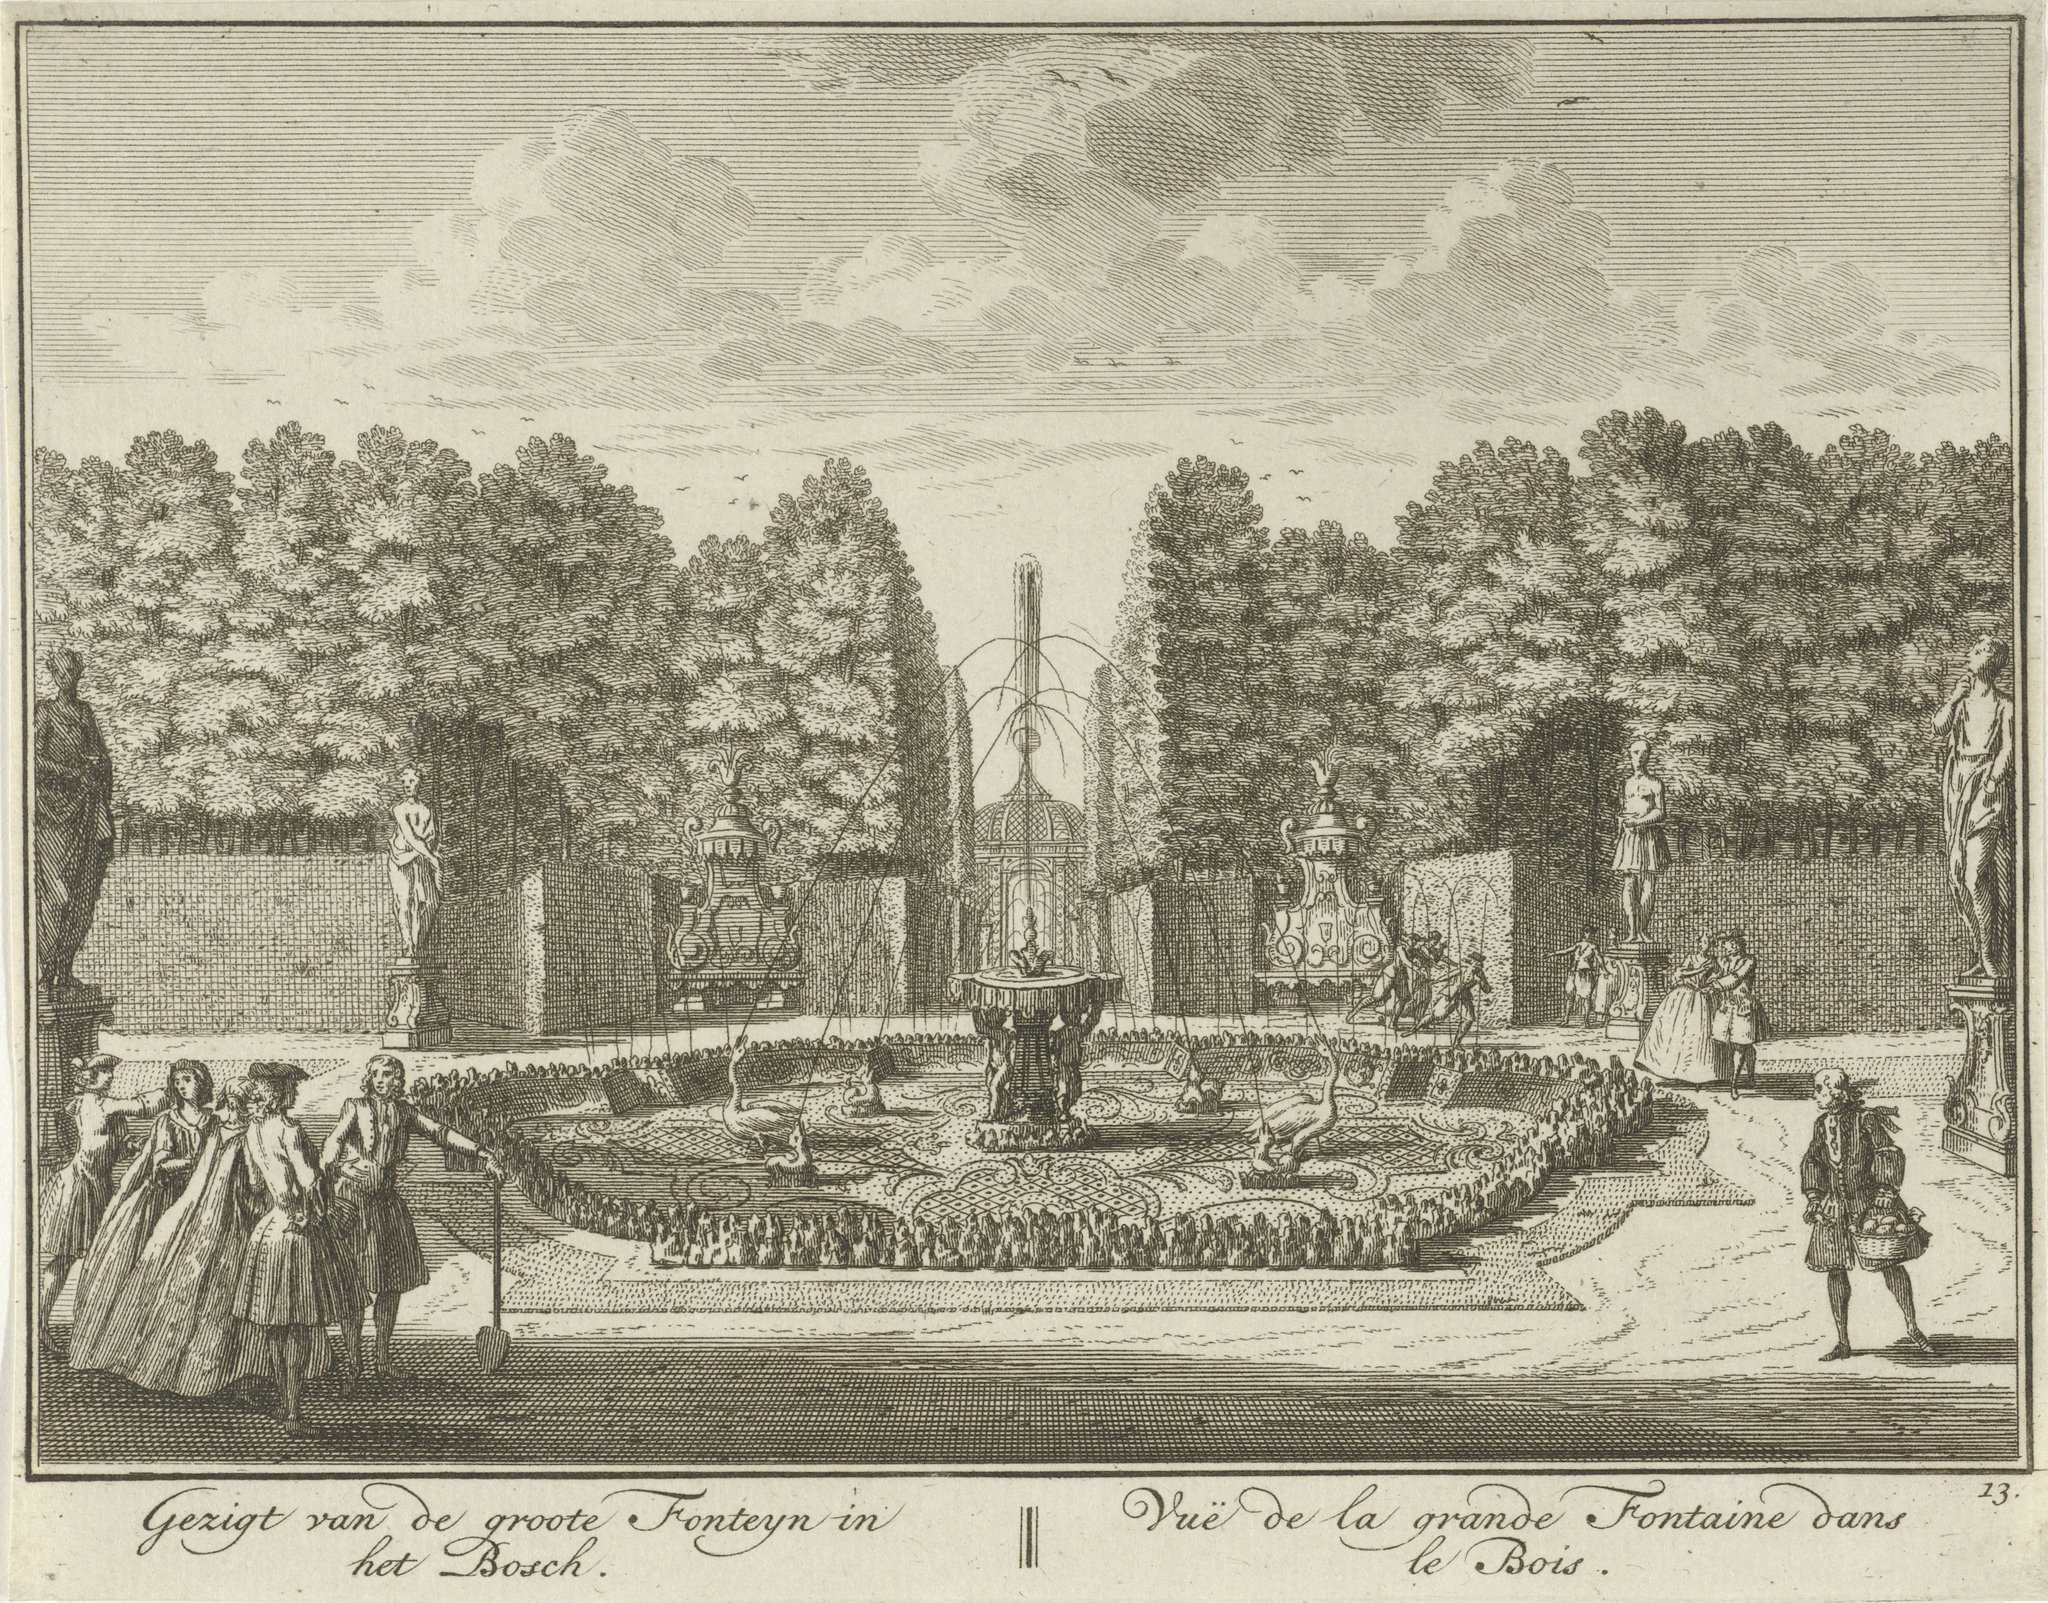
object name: print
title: Grote fontein in de tuin van Huis ter Meer te Maarssen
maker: hendrik de leth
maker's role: draughtsman, print maker, publisher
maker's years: 1703-1766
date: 1740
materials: paper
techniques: etching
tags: garden fountain, french or architectonic garden; formal garden, country-house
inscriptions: collector's mark: Lugt 2228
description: Gezicht op de grote fontein in de Franse tuin van Huis ter Meer, rondom staan figuren. De prent maakt deel uit van een serie met 26 gezichten op Huis ter Meer en het bijbehorende landgoed te Maarssen.